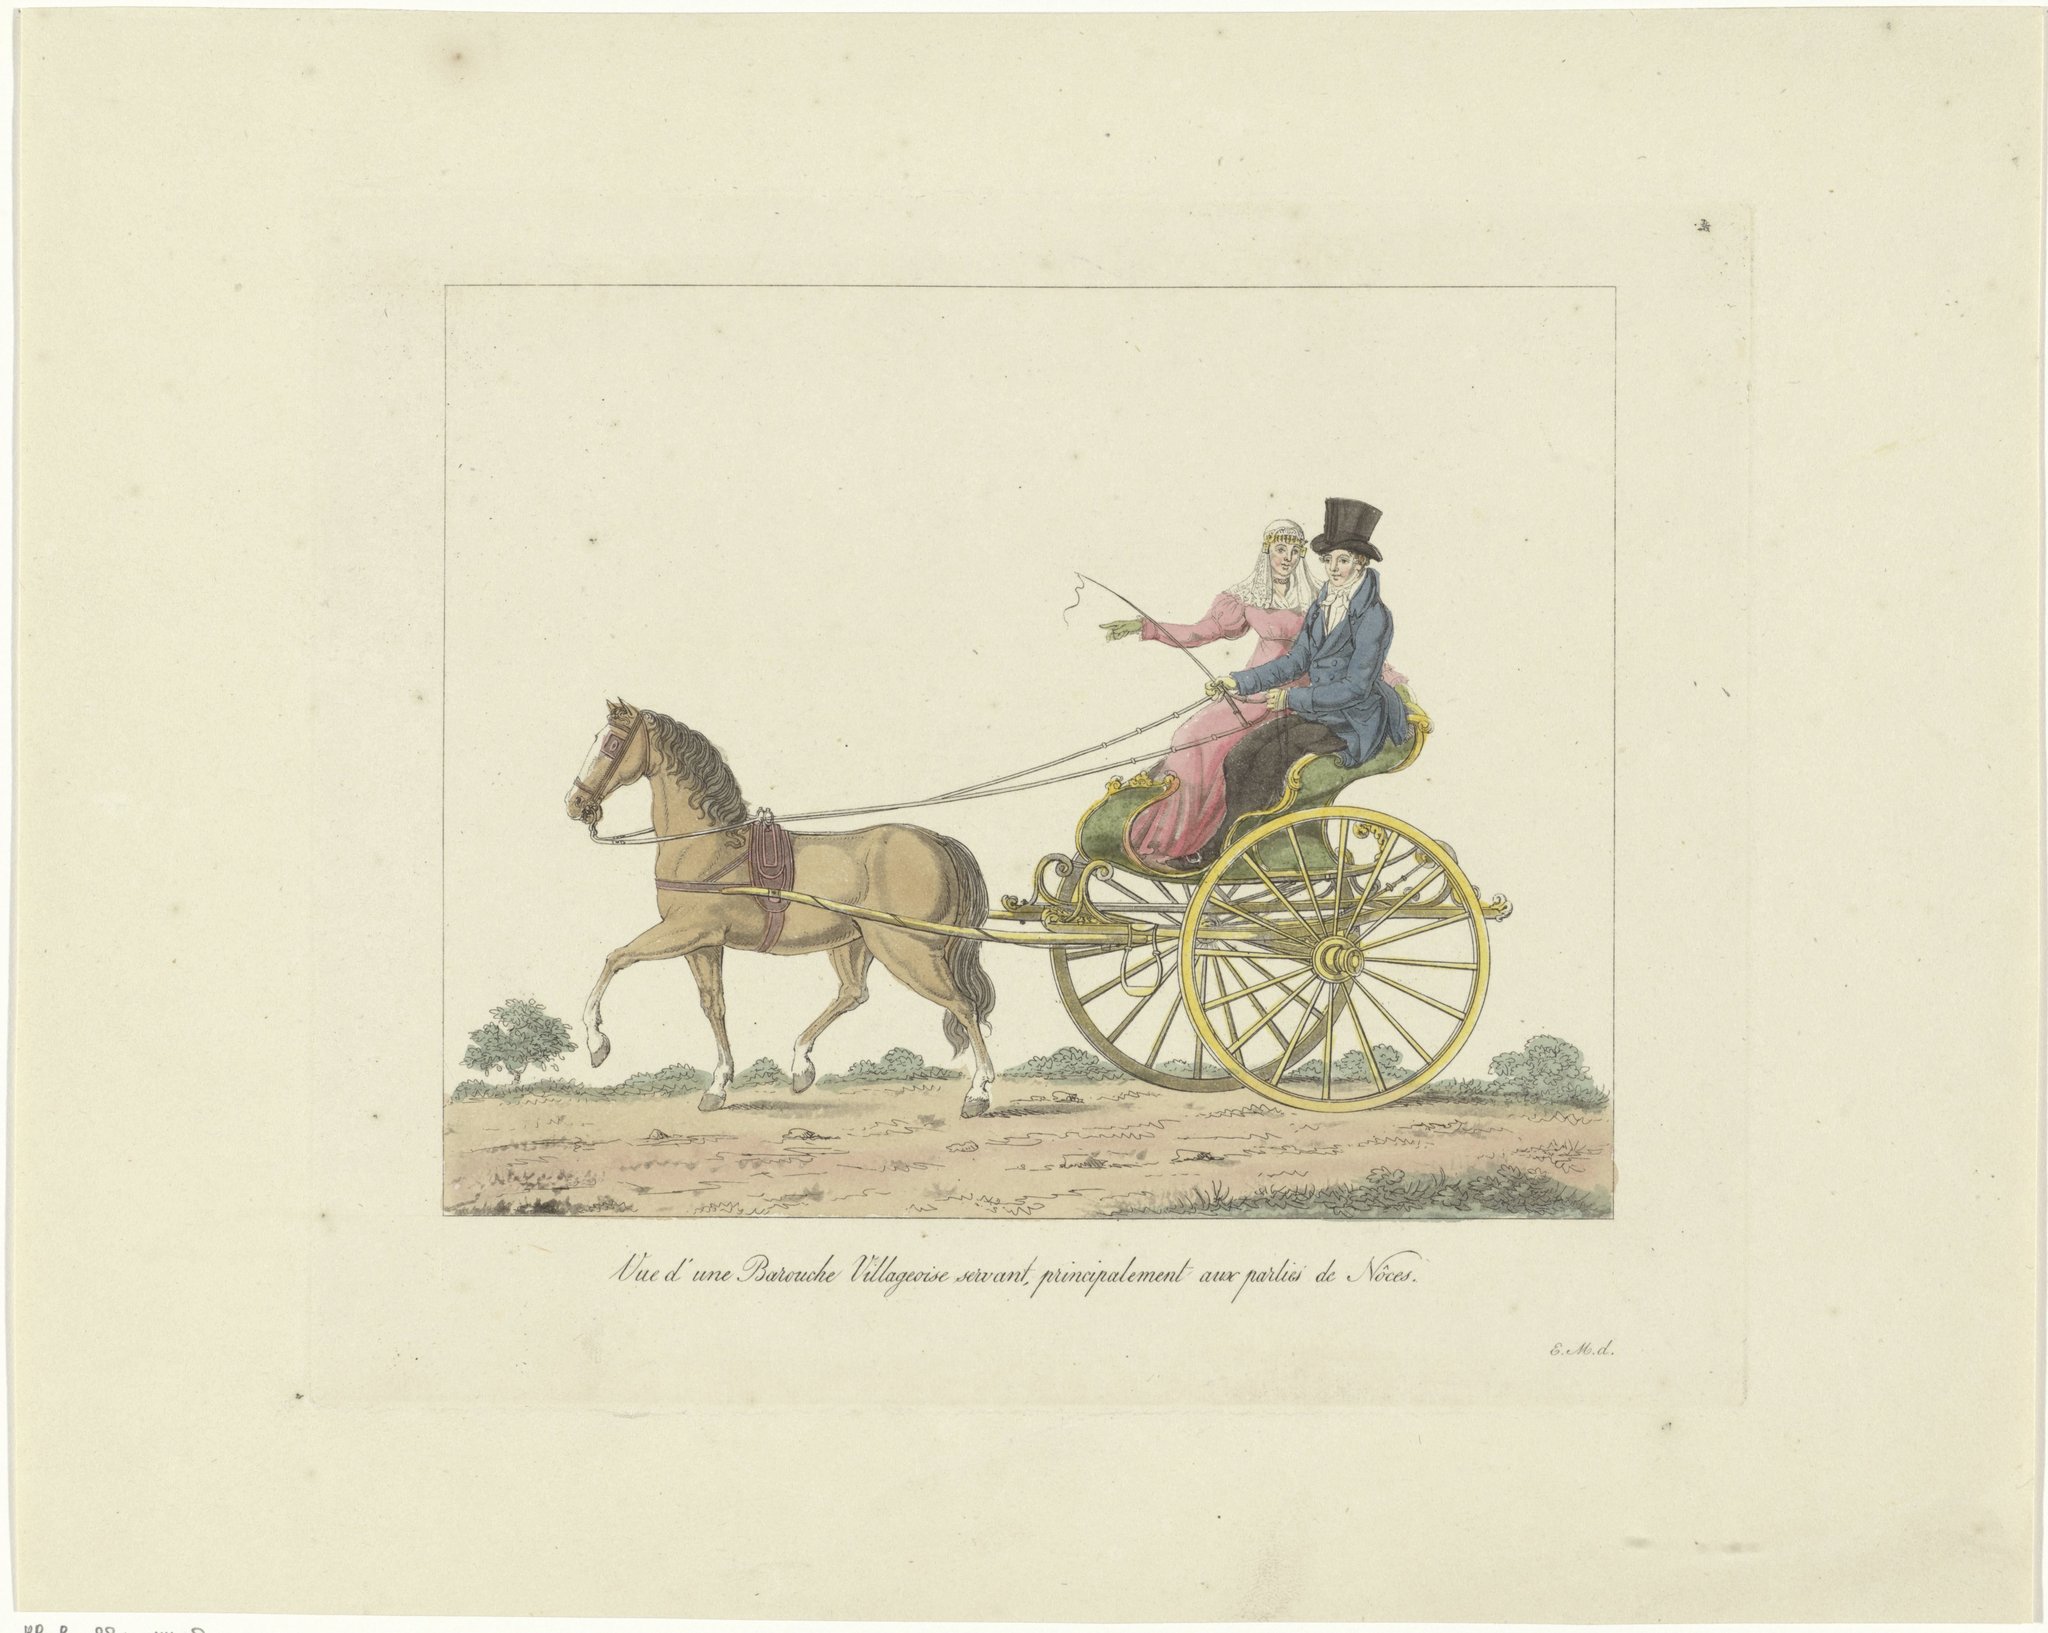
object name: print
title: Paar in een koets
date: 1824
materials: paper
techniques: aquatint, etching, hand coloring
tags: two-wheeled vehicle drawn by one animal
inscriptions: collector's mark: Lugt 2228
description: Prent gebruikt in: Maaskamp, Evert. Tableau des principales vues des palais et édifices : représentations et des coutumes et usages, dans les provinces septentrionales du Royaume des Pays-Bas. Amsterdam, 1824.